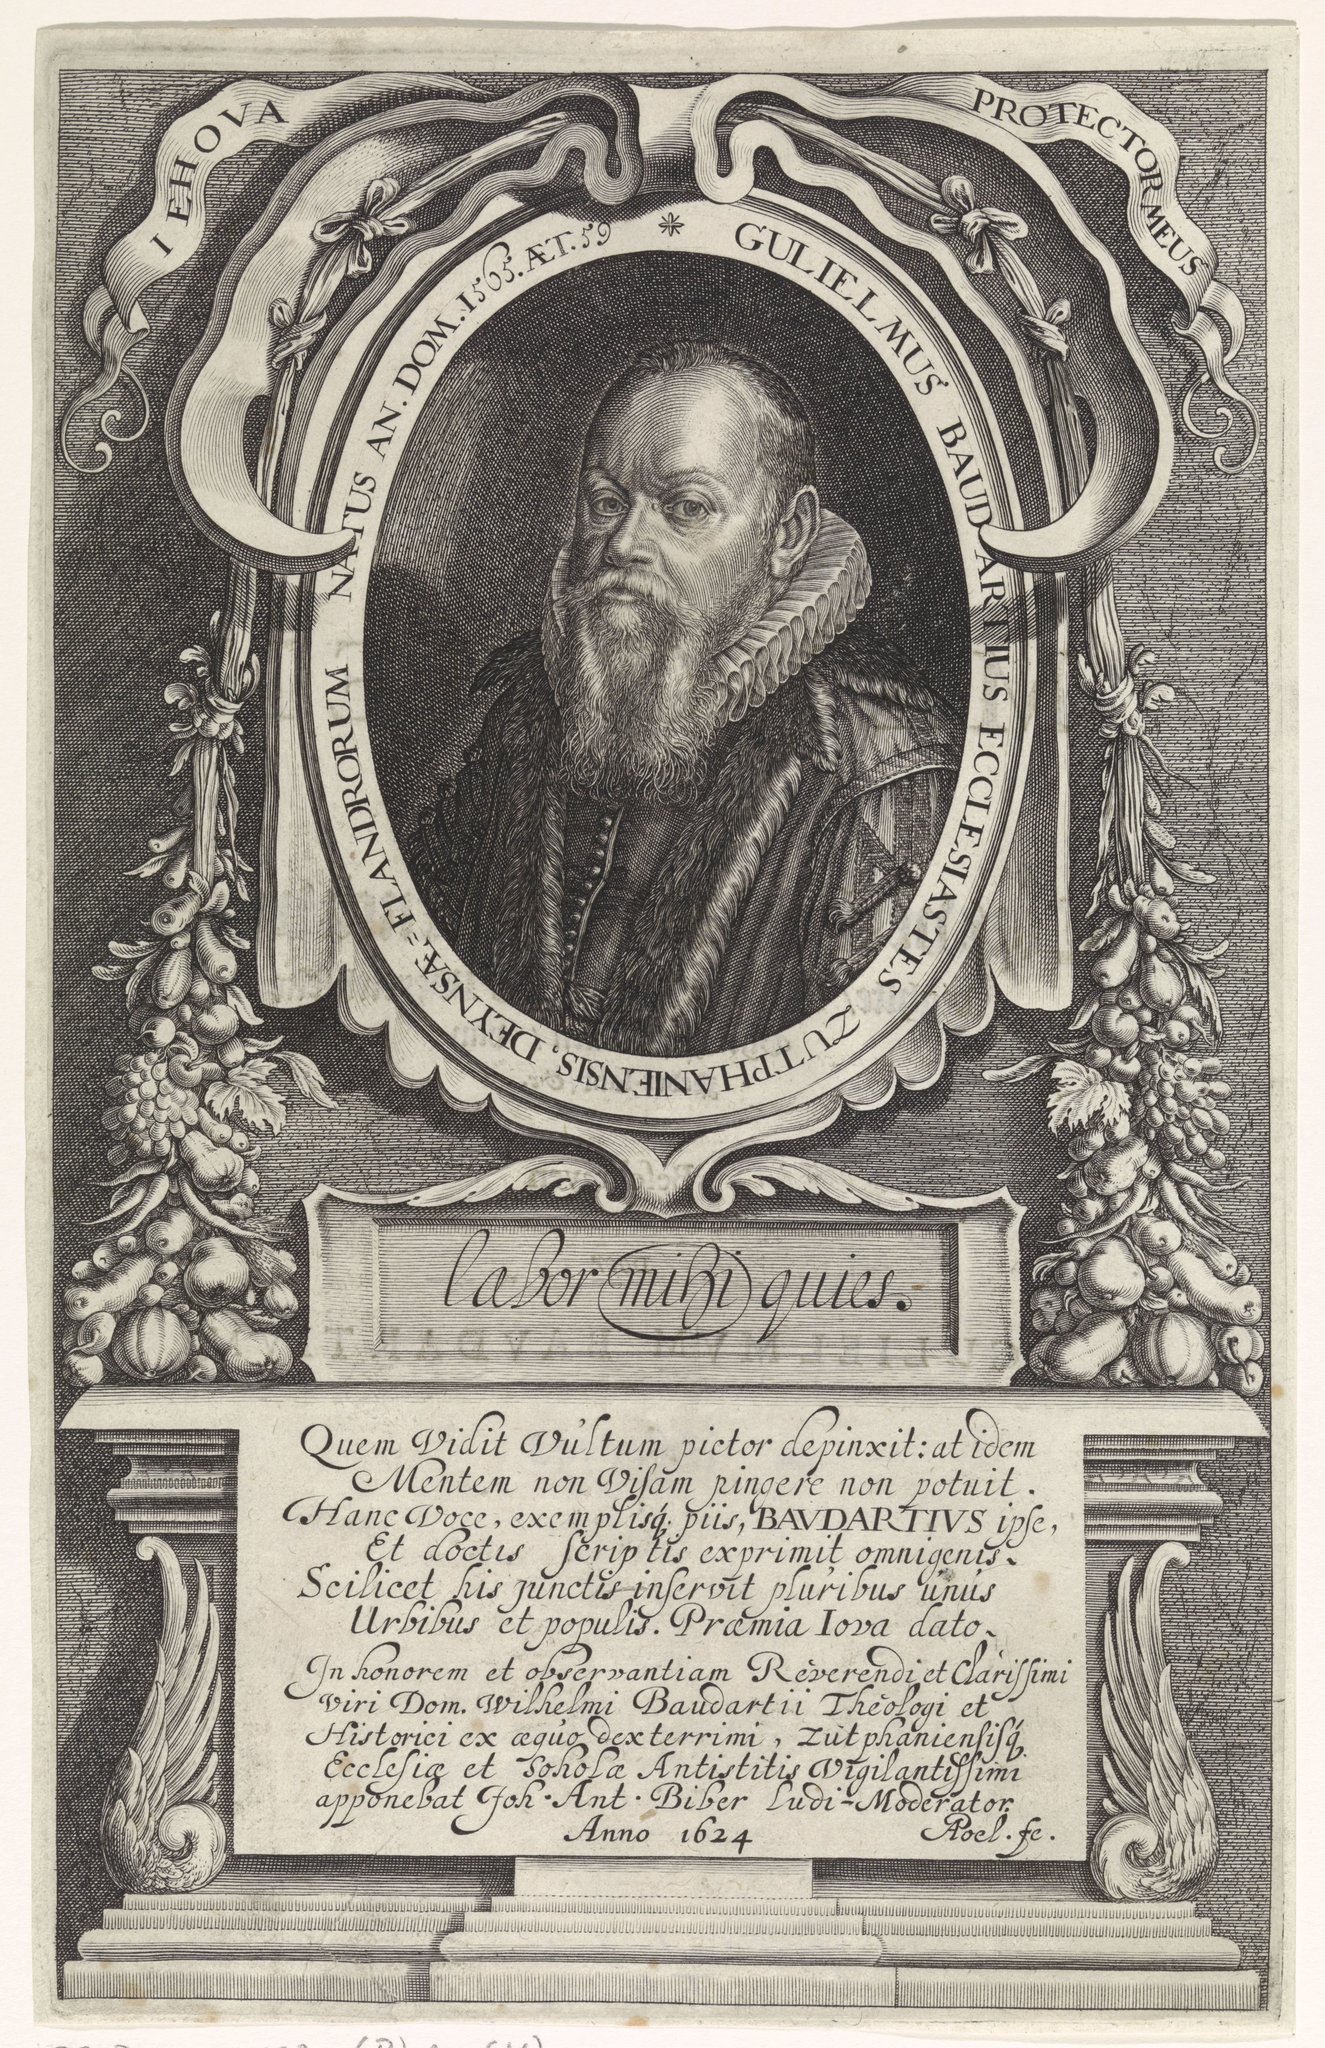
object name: print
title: Portret van Willem Baudartius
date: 1624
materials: paper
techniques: engraving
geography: arnhem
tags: deinze, zutphen (stad), theoloog, historicus, dominee, willem baudartius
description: Portret opgenomen in: Willem Baudartius. Memoryen ofte Cort verhael der gedenck-weerdichste so kercklicke als werltlicke gheschiedenissen (...) van den iaere 1603. tot in het iaer 1624. Twee delen. Tweede vermeerderde editie. Arnhem: Jan Jansz, 1624 en Zutphen: Andries Jansz van Aelst, 1624. Op versozijde Franse titelpagina.